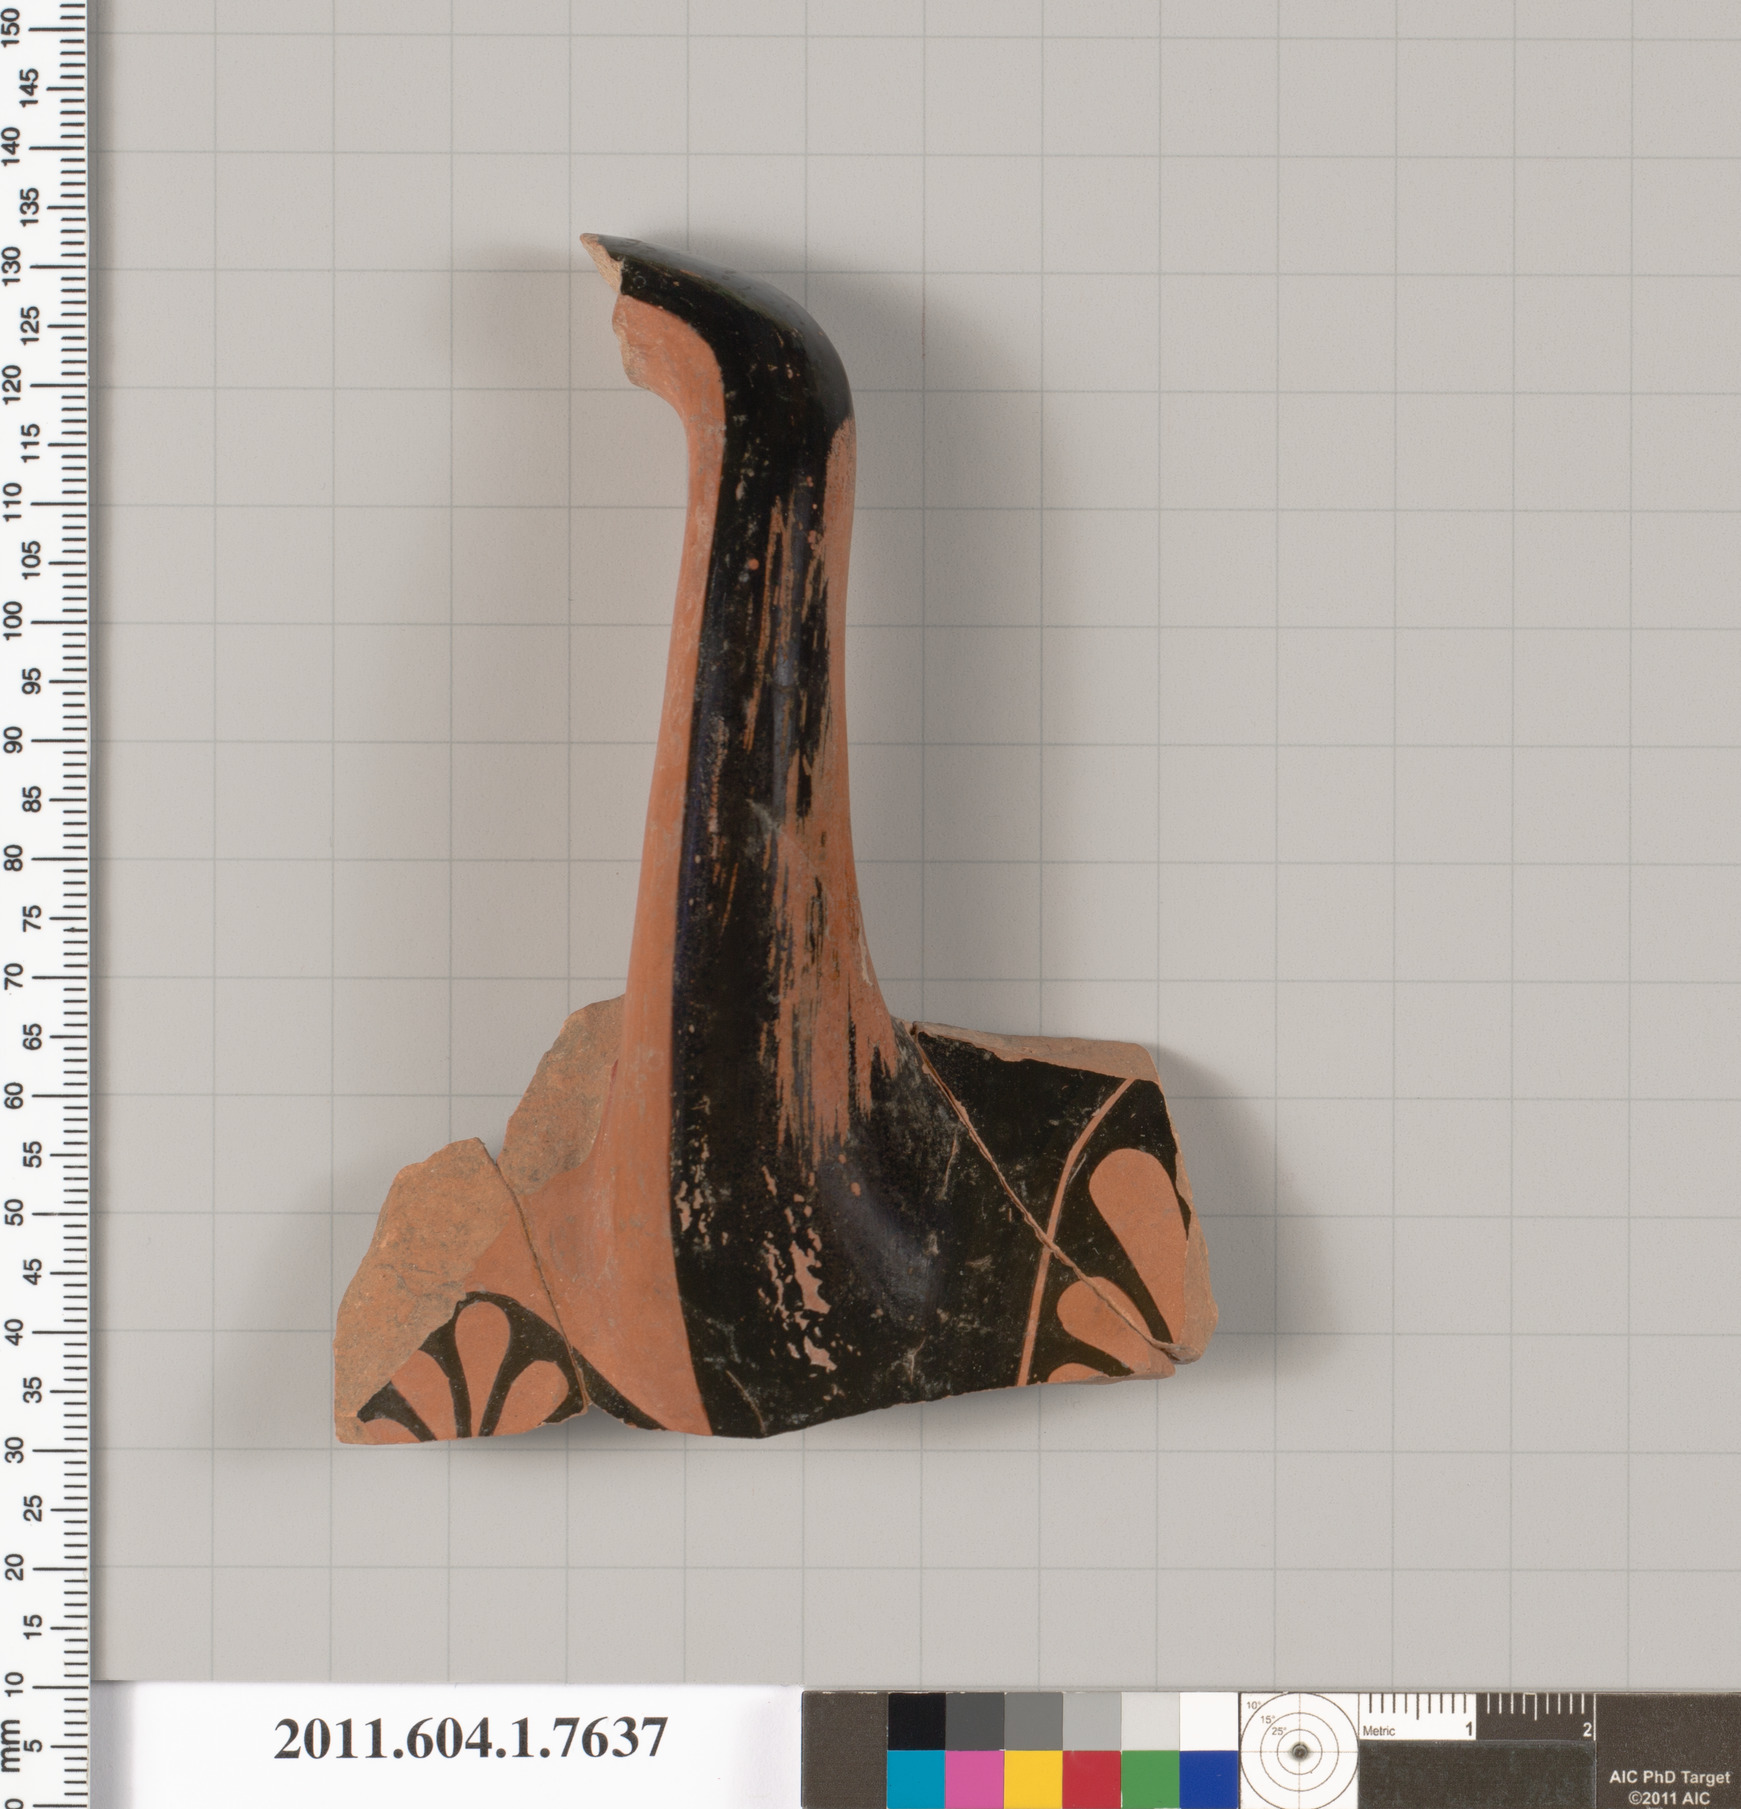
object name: kylix fragment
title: Terracotta fragment of a kylix (drinking cup)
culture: greek, attic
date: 460-450 BCE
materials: terracotta